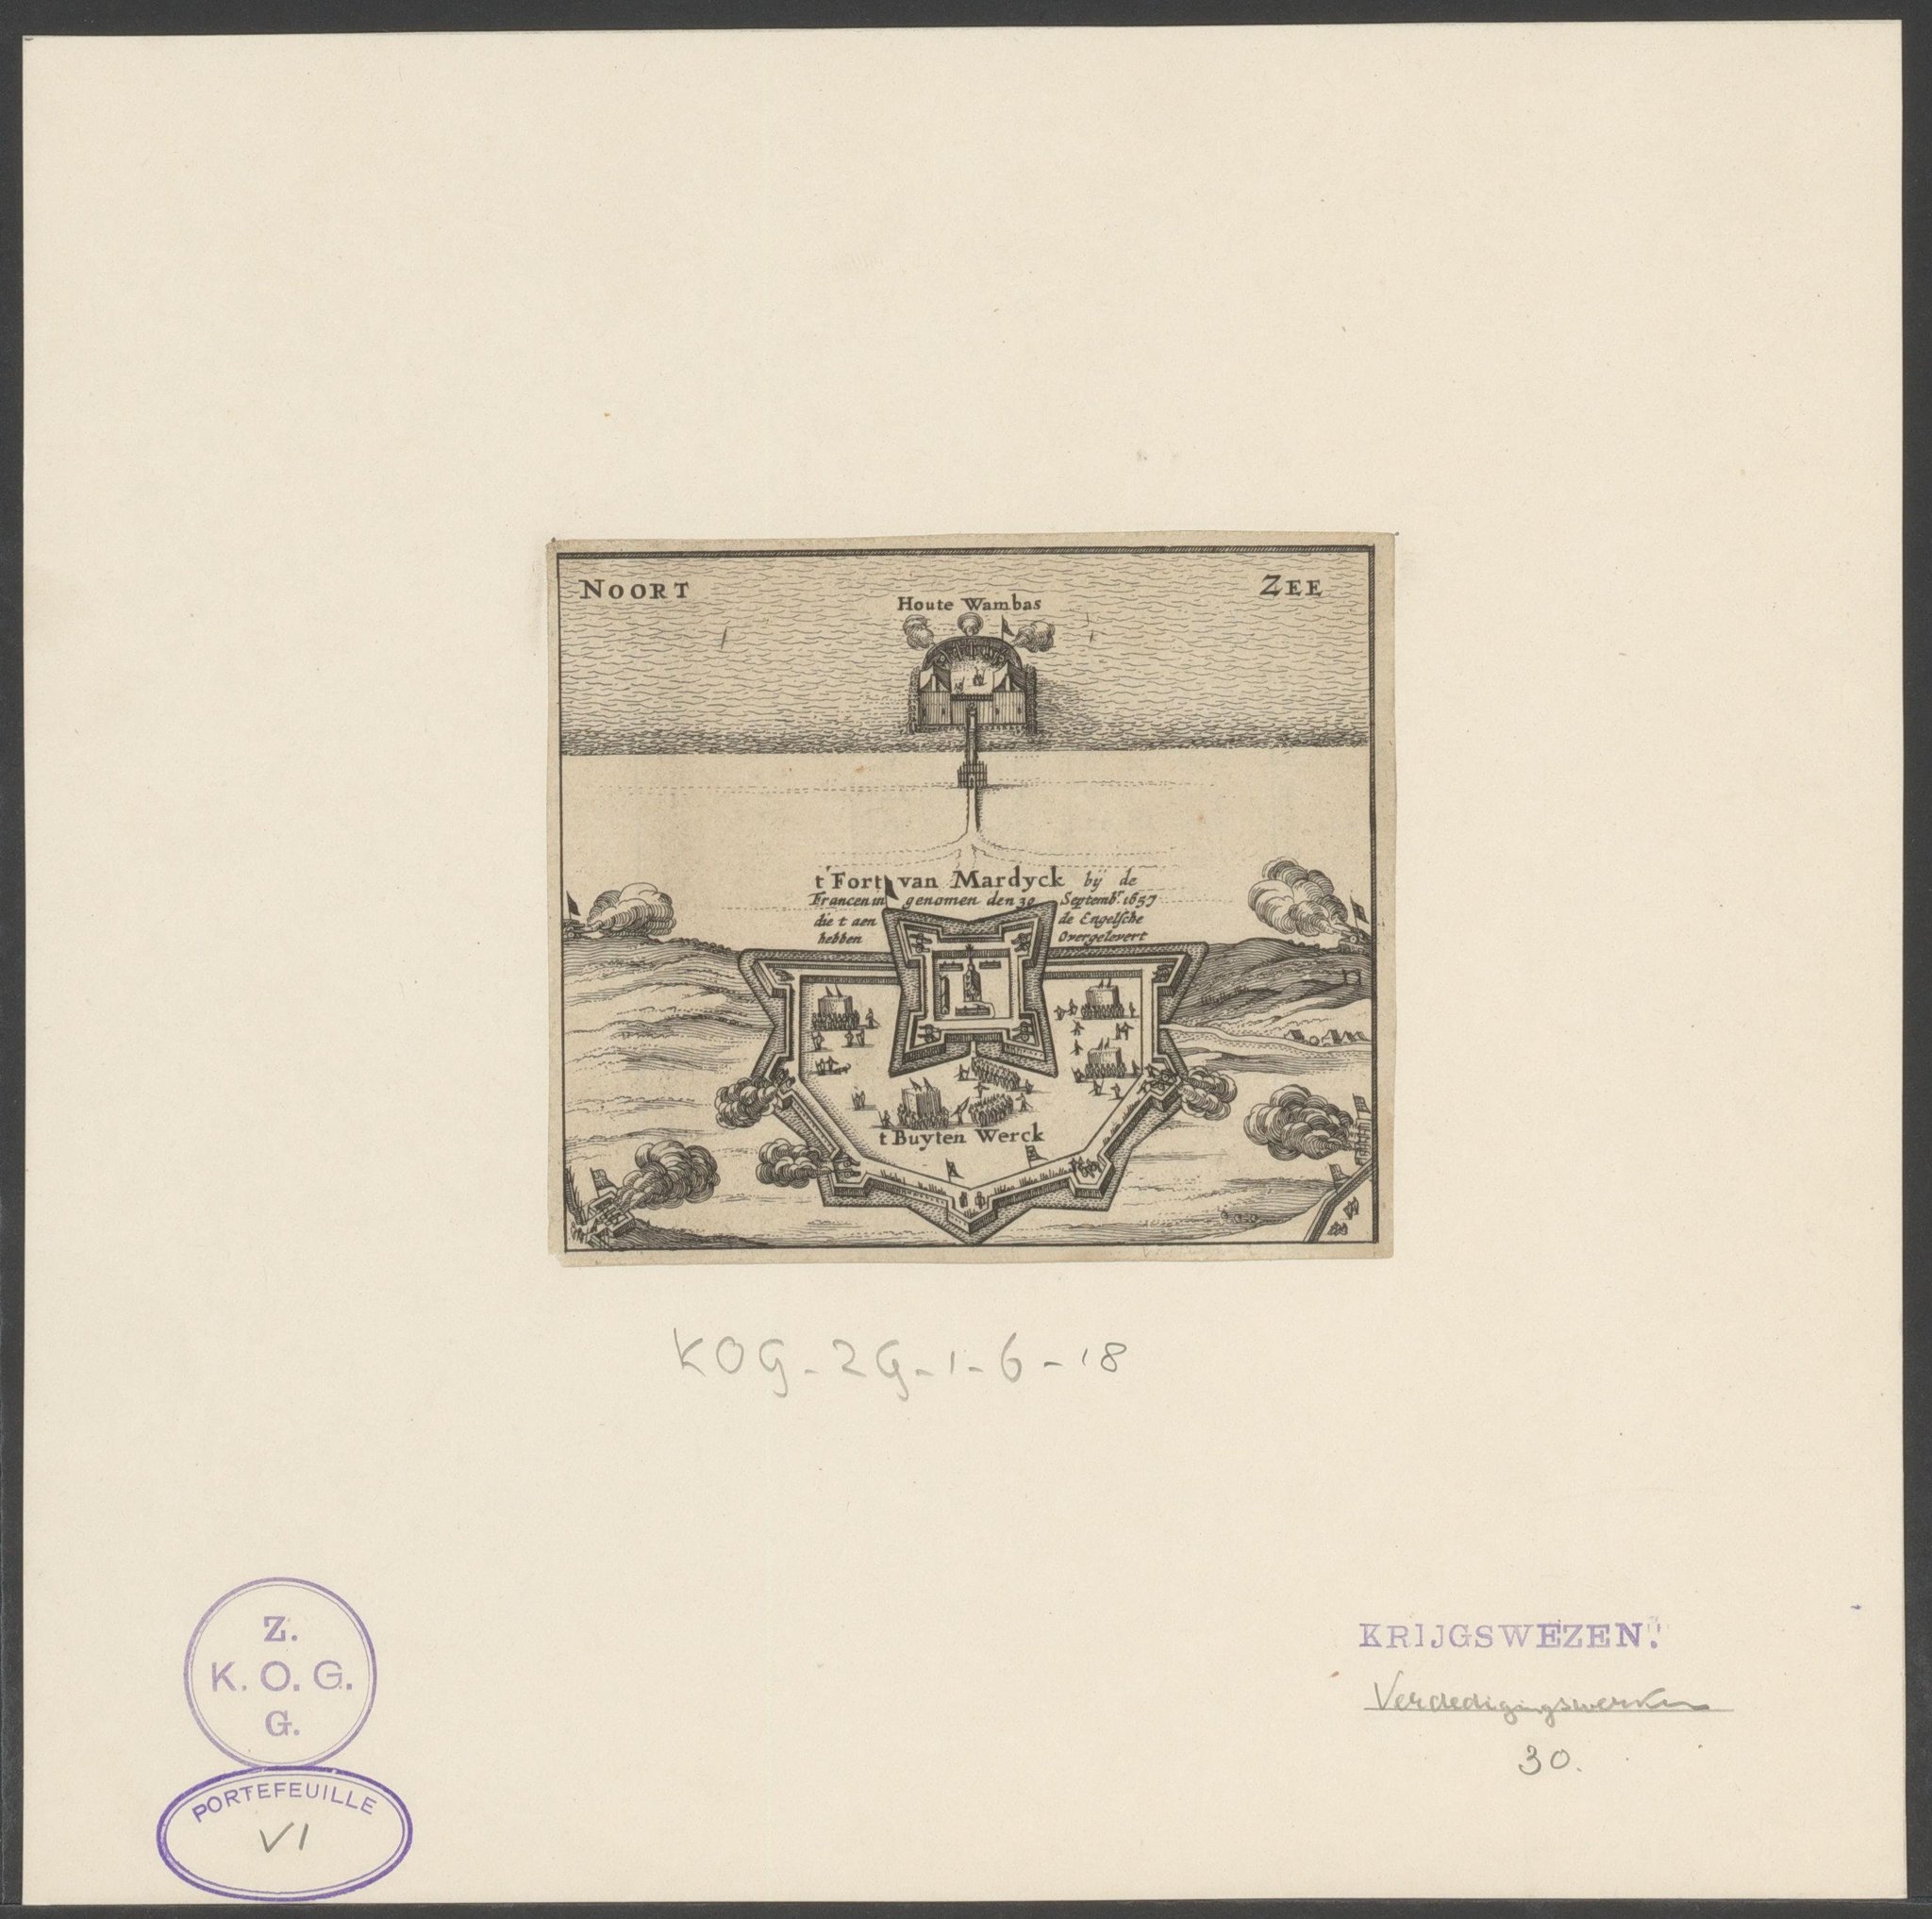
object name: print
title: Beleg van fort Mardijk, 1645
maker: Anonymous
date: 1645-1749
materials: paper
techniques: engraving, etching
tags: fortress, sea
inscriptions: stamp, collector's mark: Lugt 1641, stamp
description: Beleg en verovering van het fort Mardijk bij het plaatsje Mardijk bij Duinkerken, 22 juni - 9 juli 1645, door het Franse leger onder Gaston, hertog van Orleans op de Spanjaarden. Bovenaan een profiel van het fort Mardijk aan het strand met de schans het Houten Wambus, daaronder een plan van het fort en het omliggende land met de legerkampen van de belegeraars. Het fort omsingeld door het Franse leger. Op verso rijen getallen gedrukt van twee platen. Onderwerpsrubrieken binnen de Atlas Zeden en Gewoonten: Krijgswezen, Verdedigingswerken.